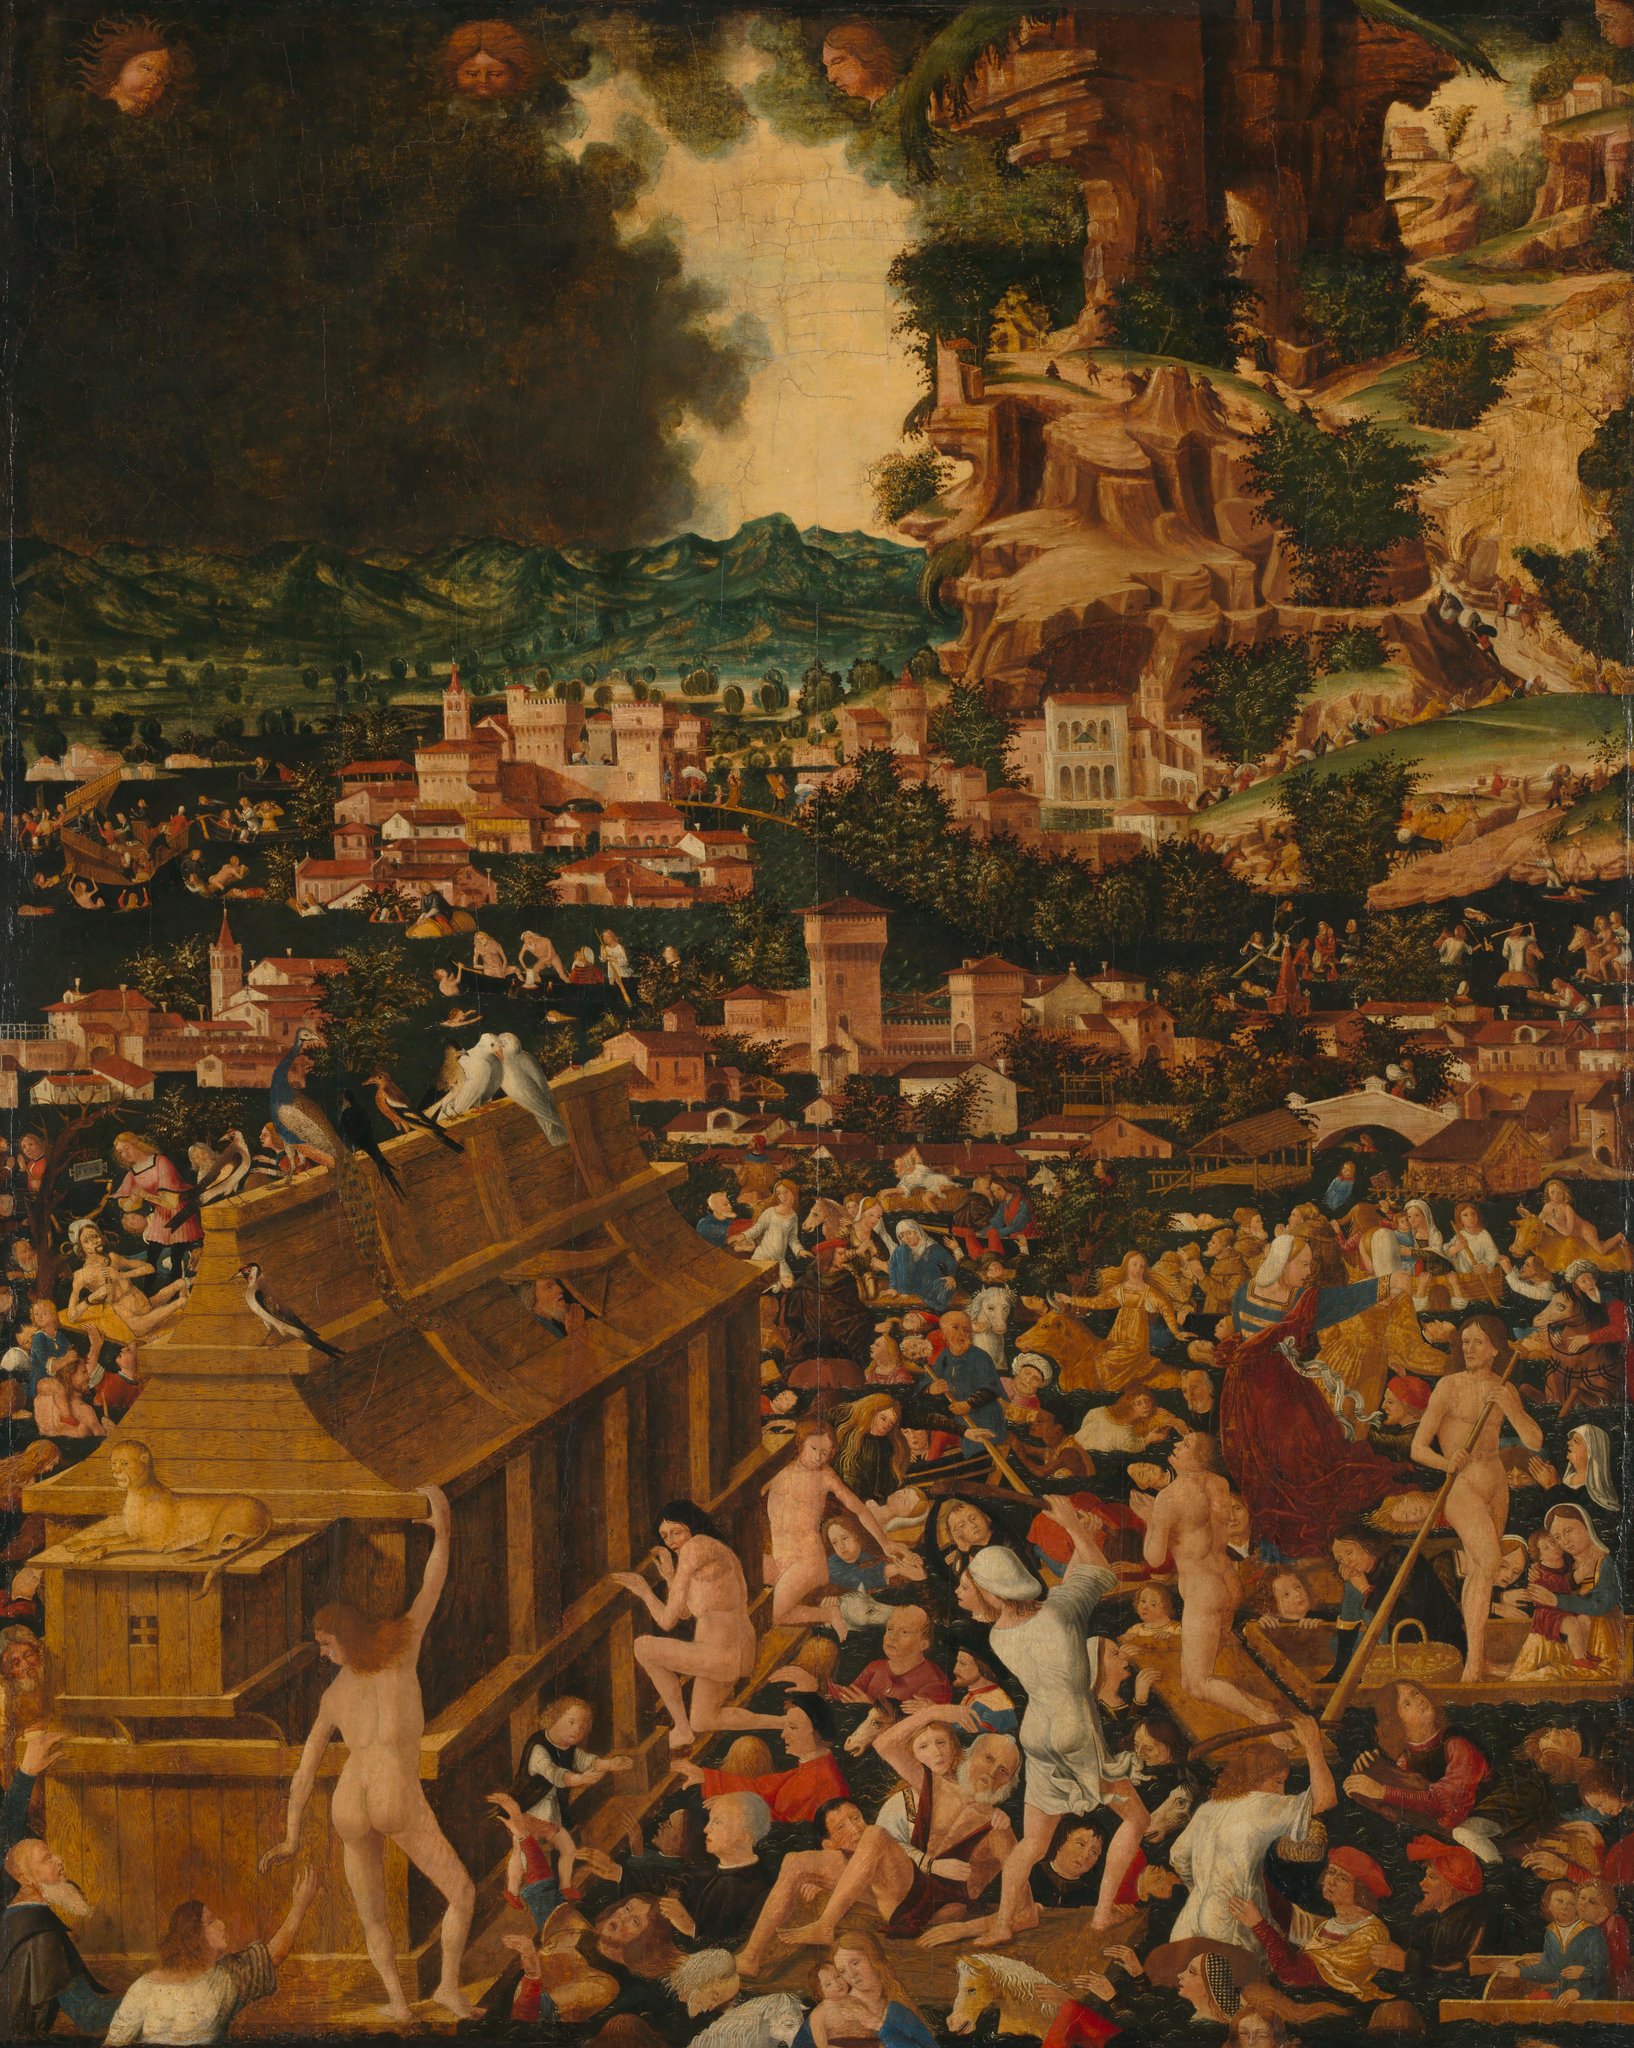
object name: painting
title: The Flood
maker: Anonymous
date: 1450-1499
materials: oil, panel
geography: northern italy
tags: the ark is floating on the waters, while life on earth is destroyed ~ story of noah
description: De Zondvloed. In een landschap geteisterd door watersnood probeert een grote menigte van mensen zich vast te klampen aan de ark van Noach of zich te redden met boten en vlotten. Op het dak van de ark zitten vogels. In de verte ligt een stad aan de voet van een fantastisch gebergte. Bovenaan in de lucht vier windkoppen. De voorstelling gaat terug op verschillende 15e-eeuwse Italiaanse prenten.